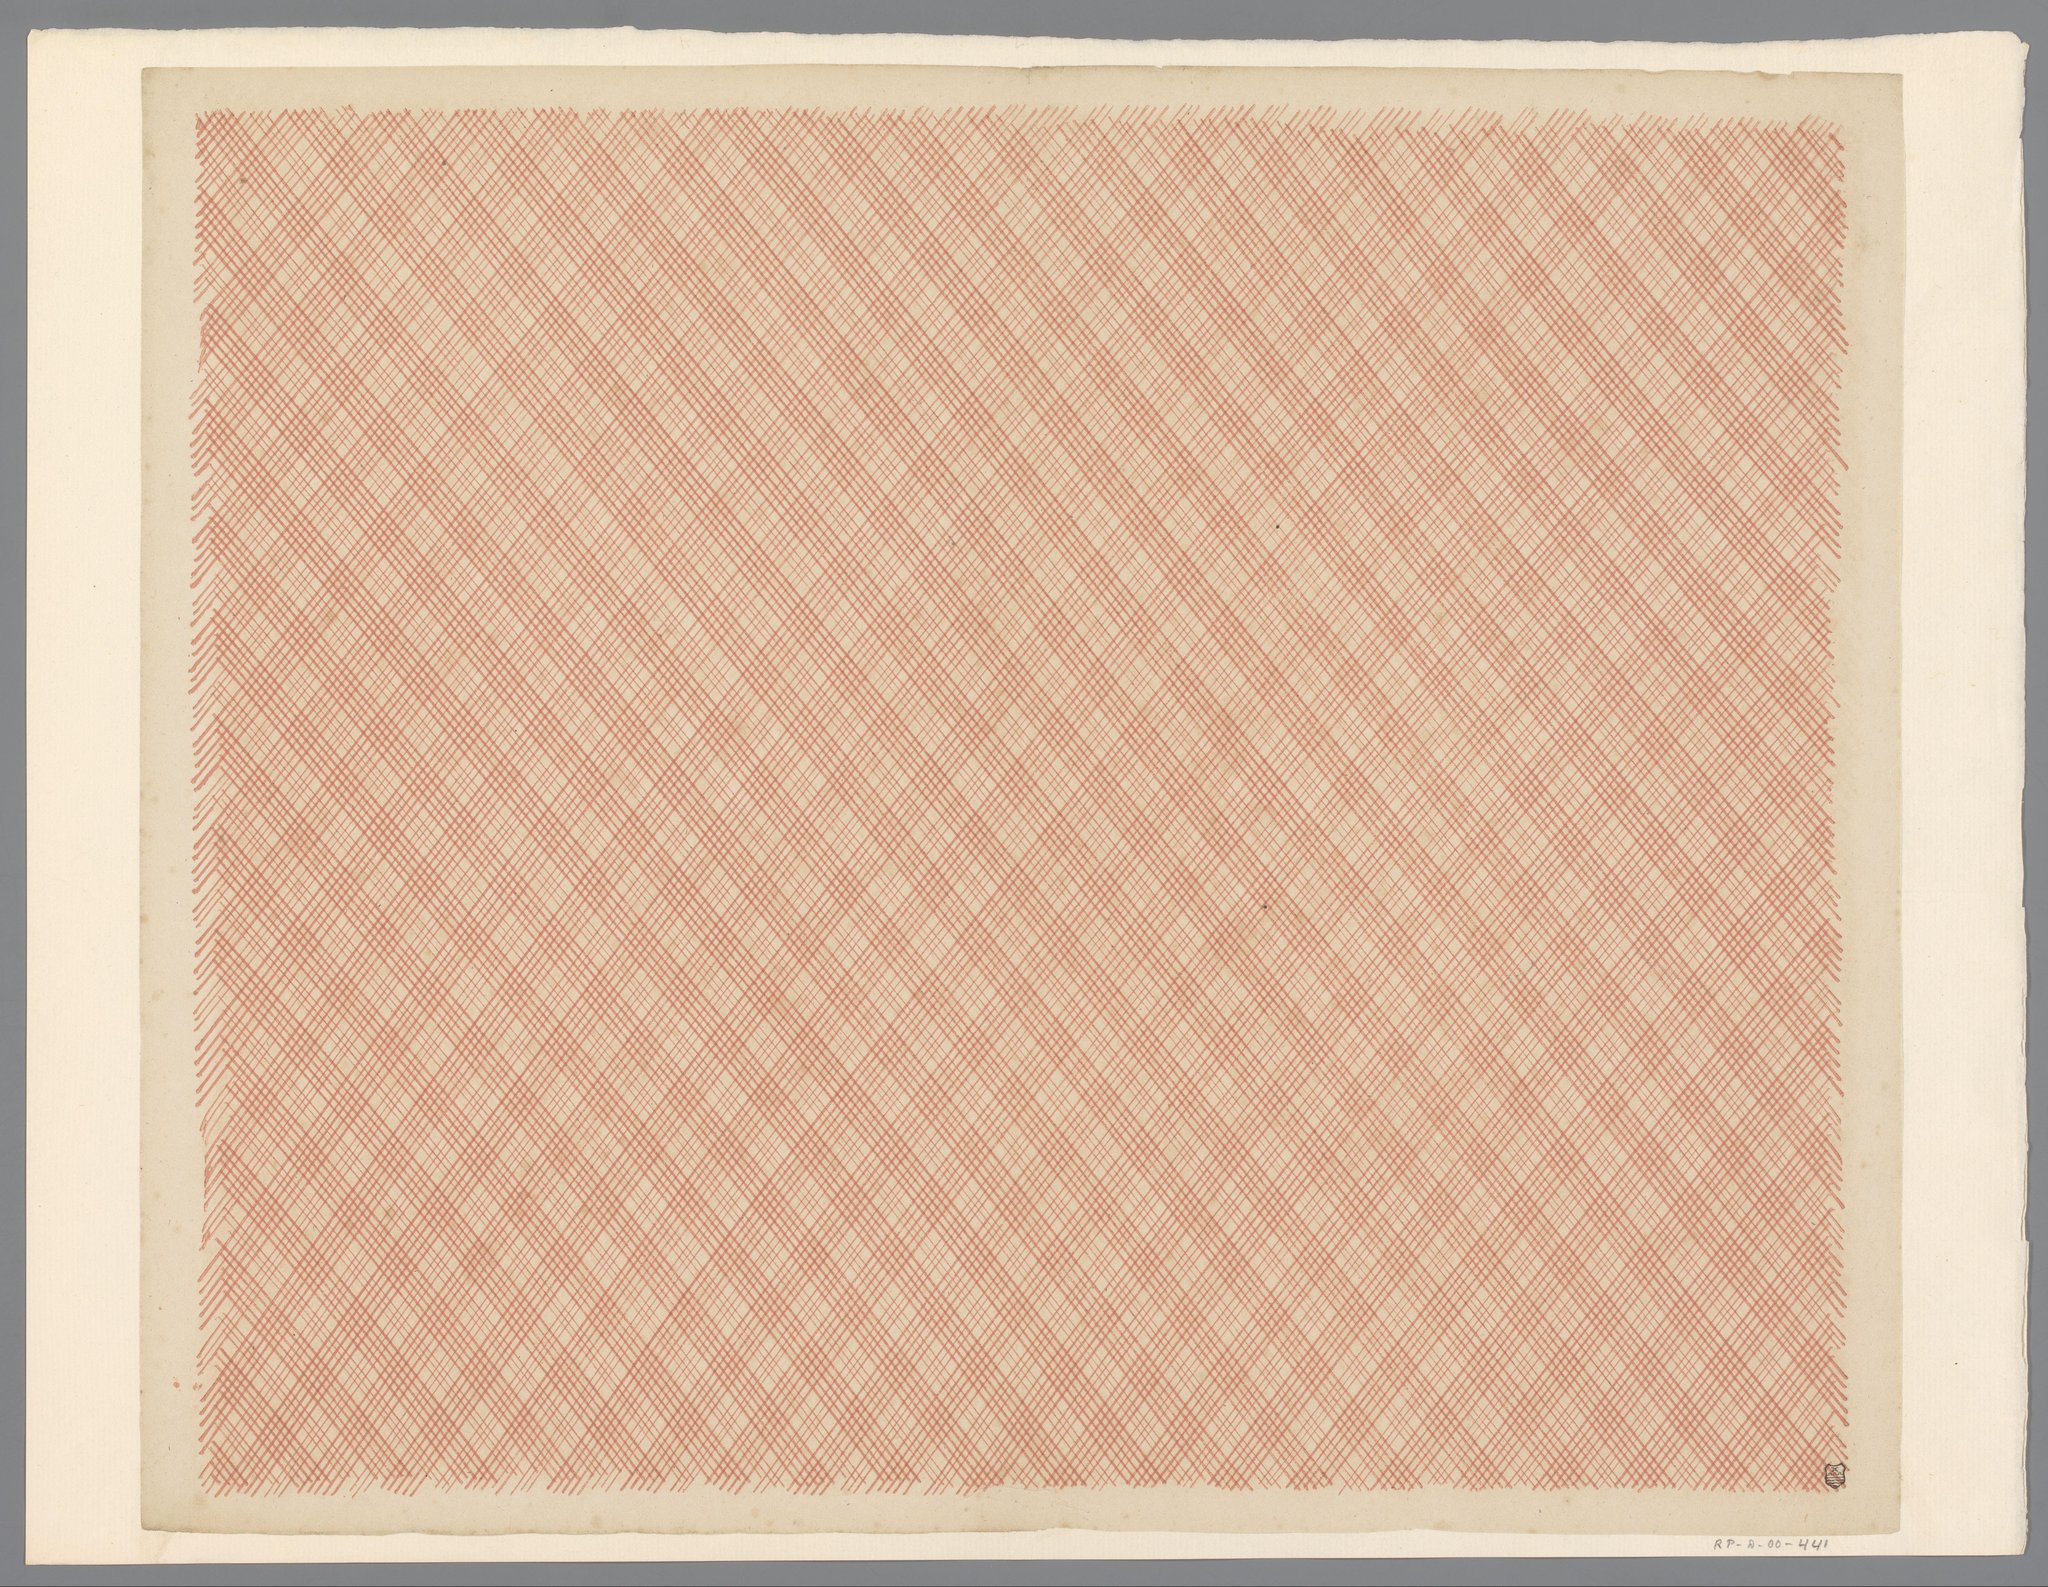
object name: printed paper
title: Blad met ruitpatroon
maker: Anonymous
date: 1800-1900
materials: paper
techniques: printing block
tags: ornament ~ geometric motifs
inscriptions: collector's mark: Lugt 2760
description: Blad met ruitpatroon in diagonale lijnen.